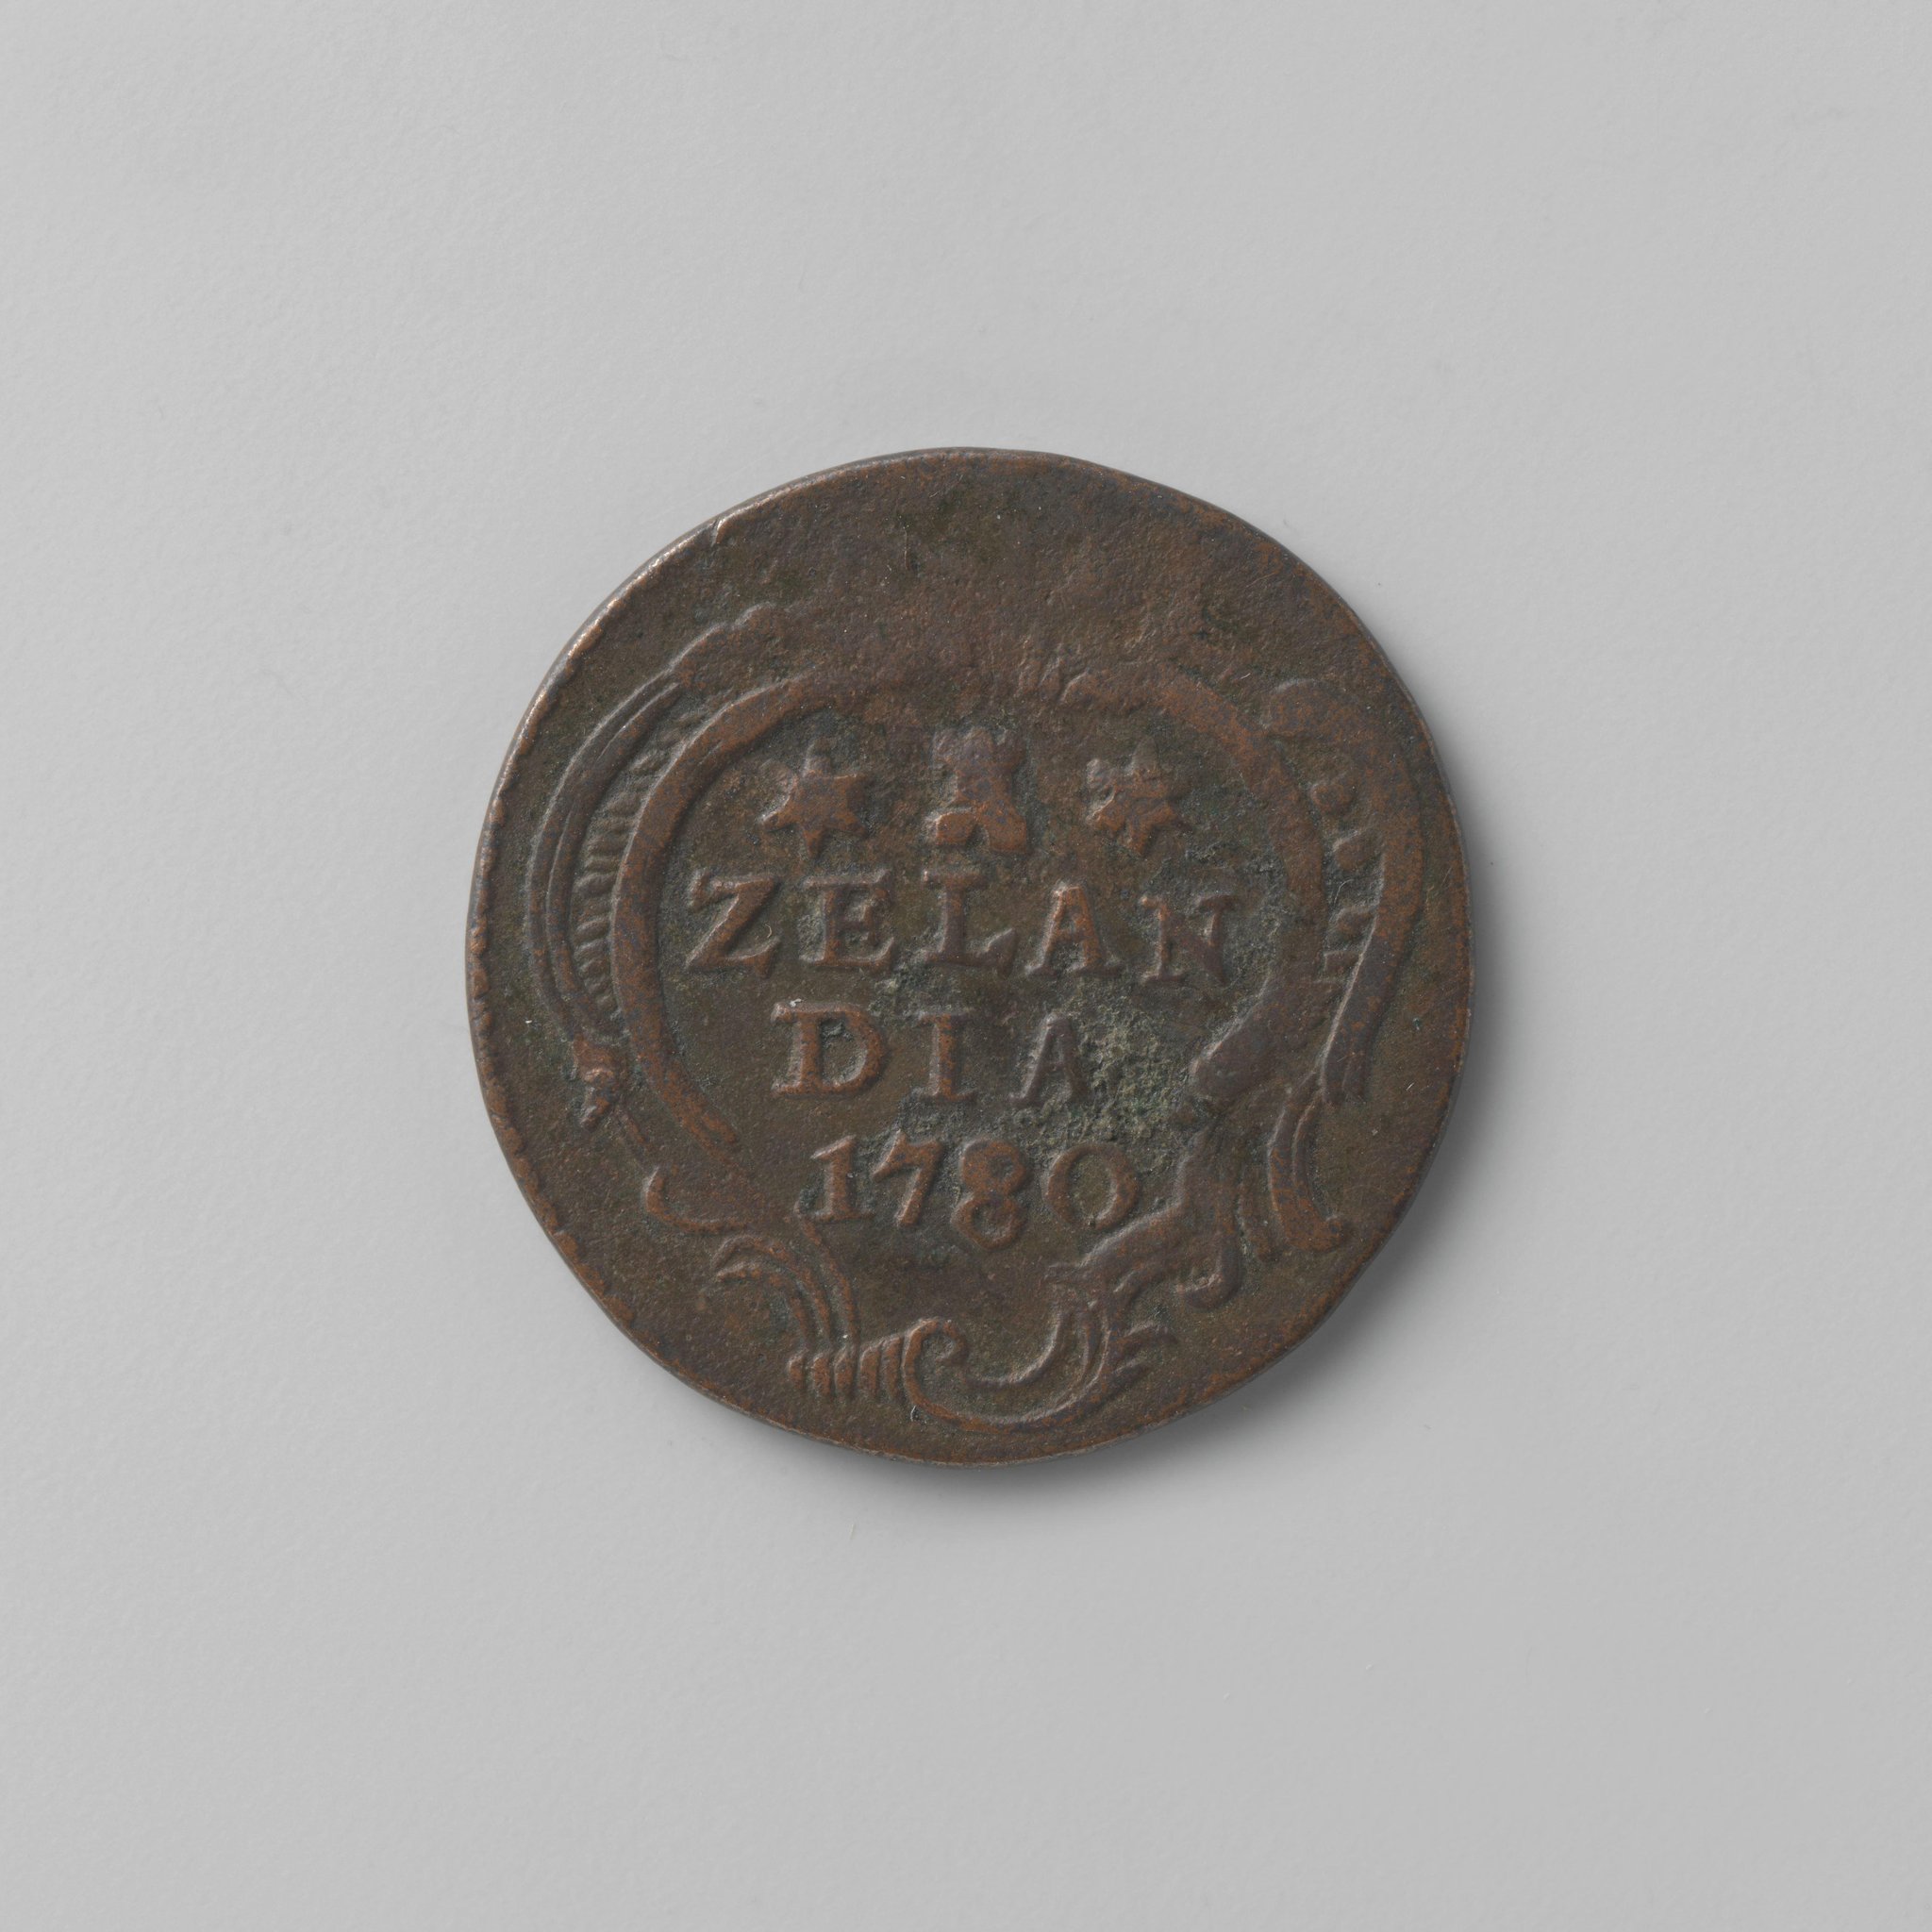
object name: coin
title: Zeeland, duit, 1780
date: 1780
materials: copper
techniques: striking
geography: middelburg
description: Koperen munt. Voorzijde: in rococo-lijst gekroond ovaal wapenschild van Zeeland. Keerzijde: in een rococo-versiering opschrift in drie regels, waarboven muntteken burcht tussen twee sterren en waaronder jaartal.